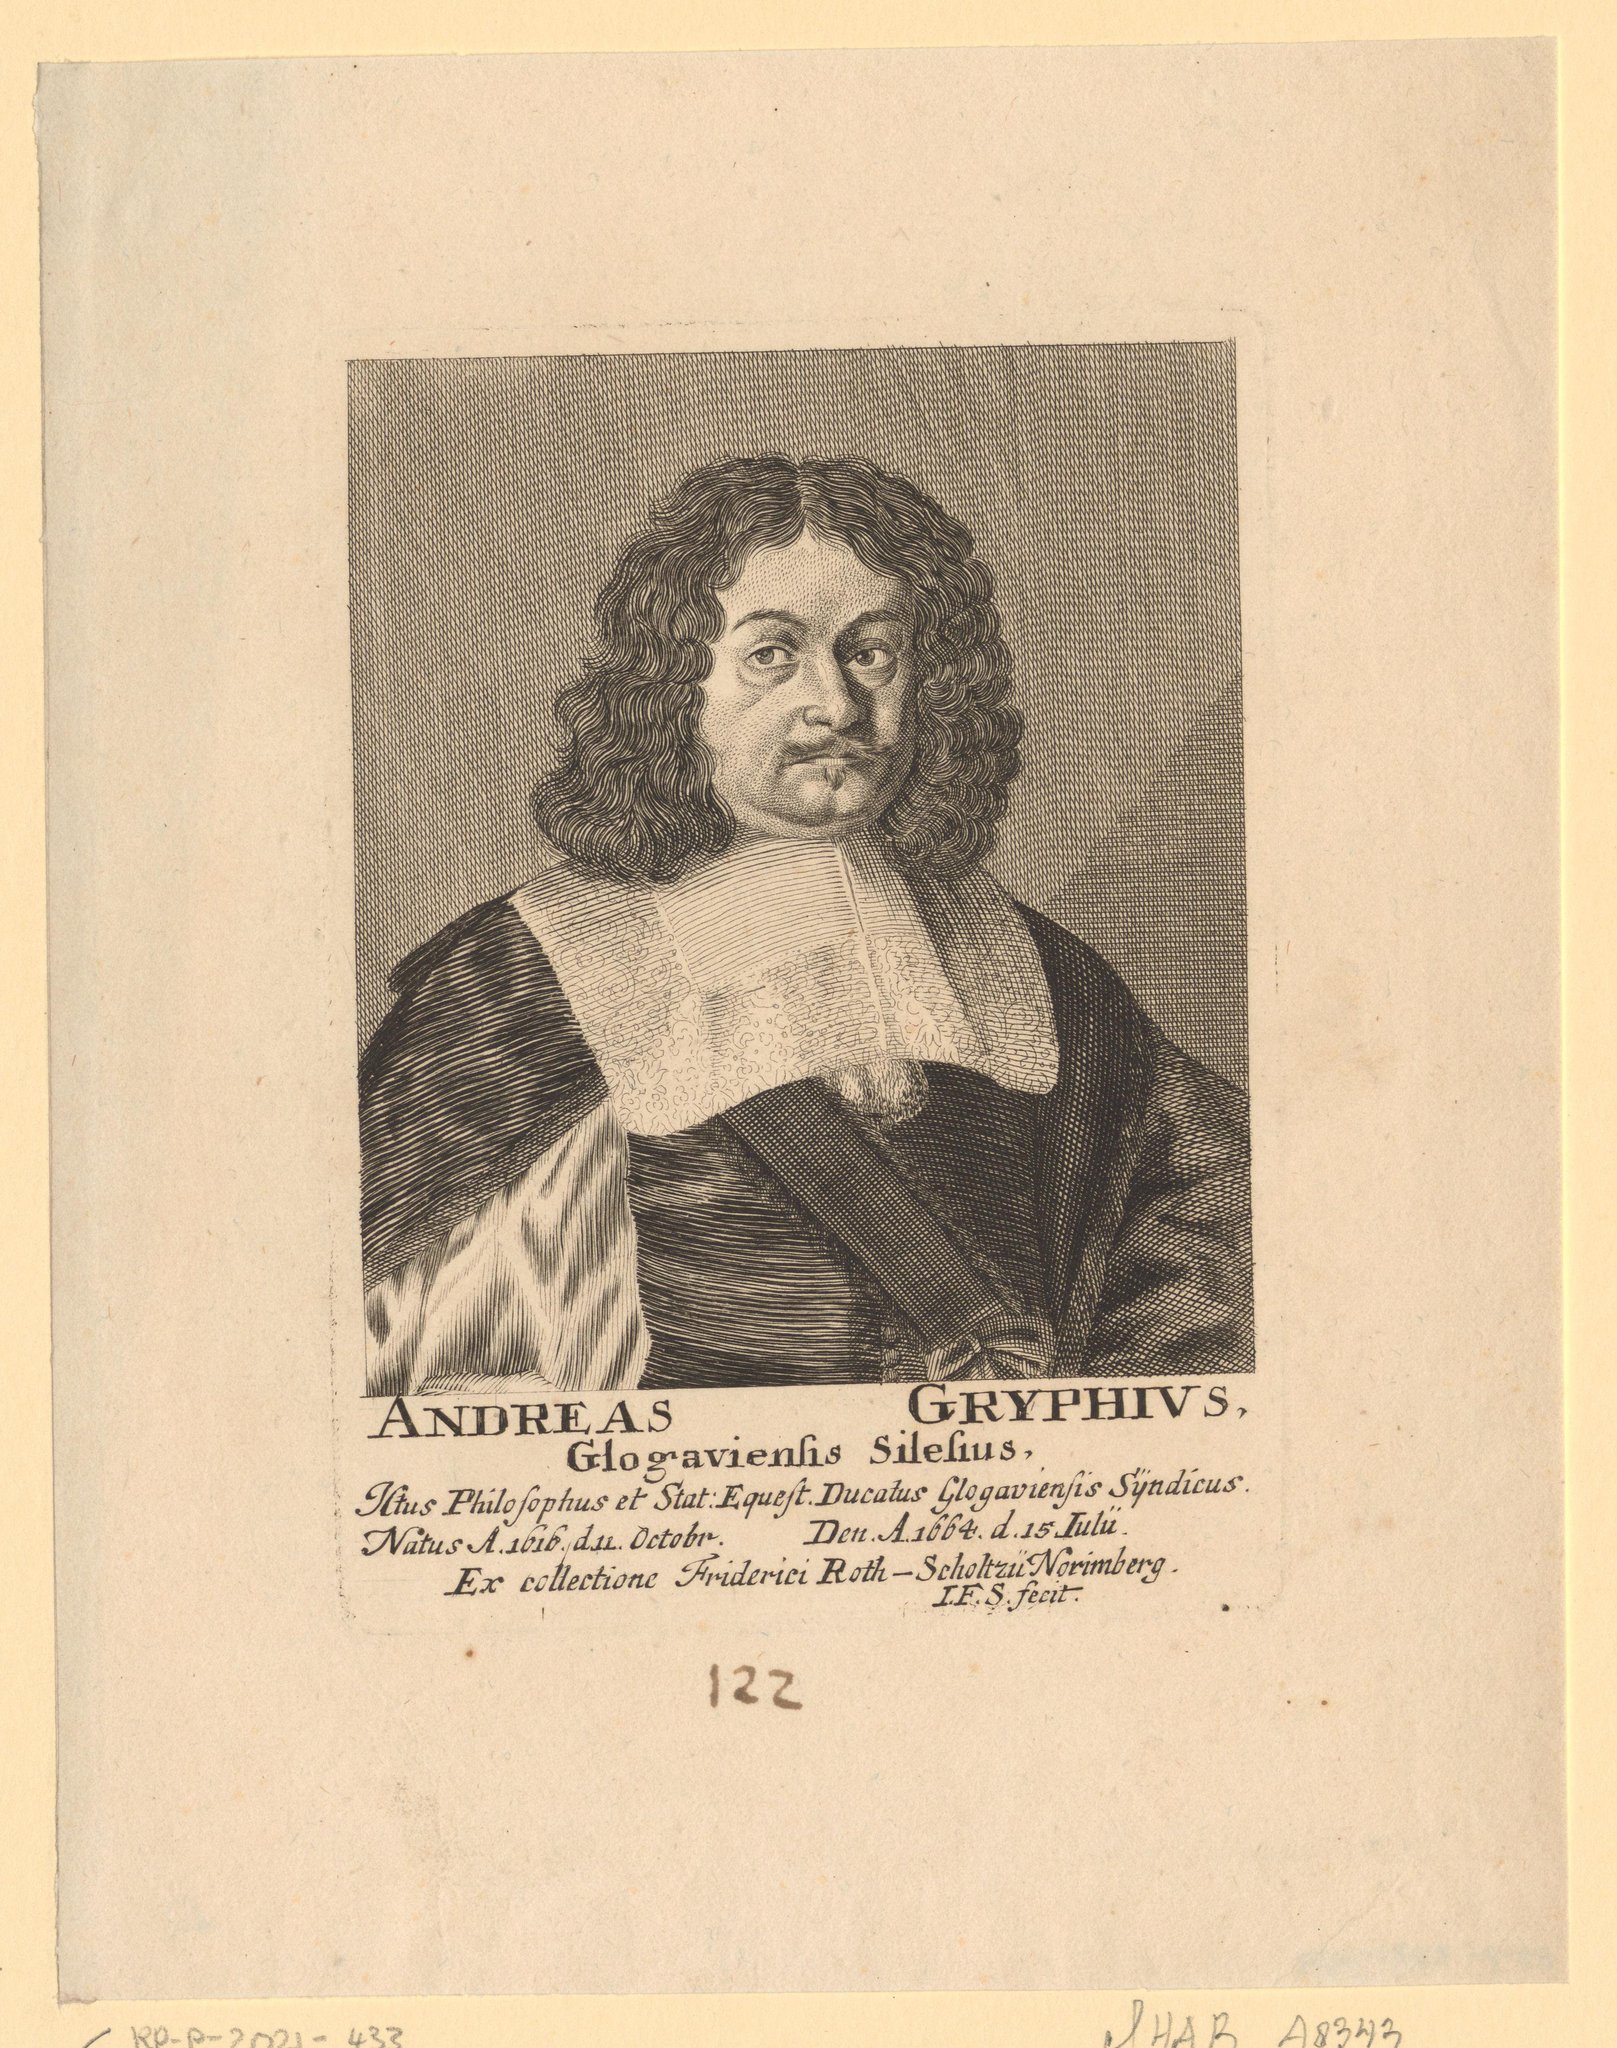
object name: print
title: Portret van Andreas Gryphius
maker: johann friedrich schmidt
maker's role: print maker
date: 1704-1765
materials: paper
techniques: engraving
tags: historical persons, portrait of a writer, writer, poet, author